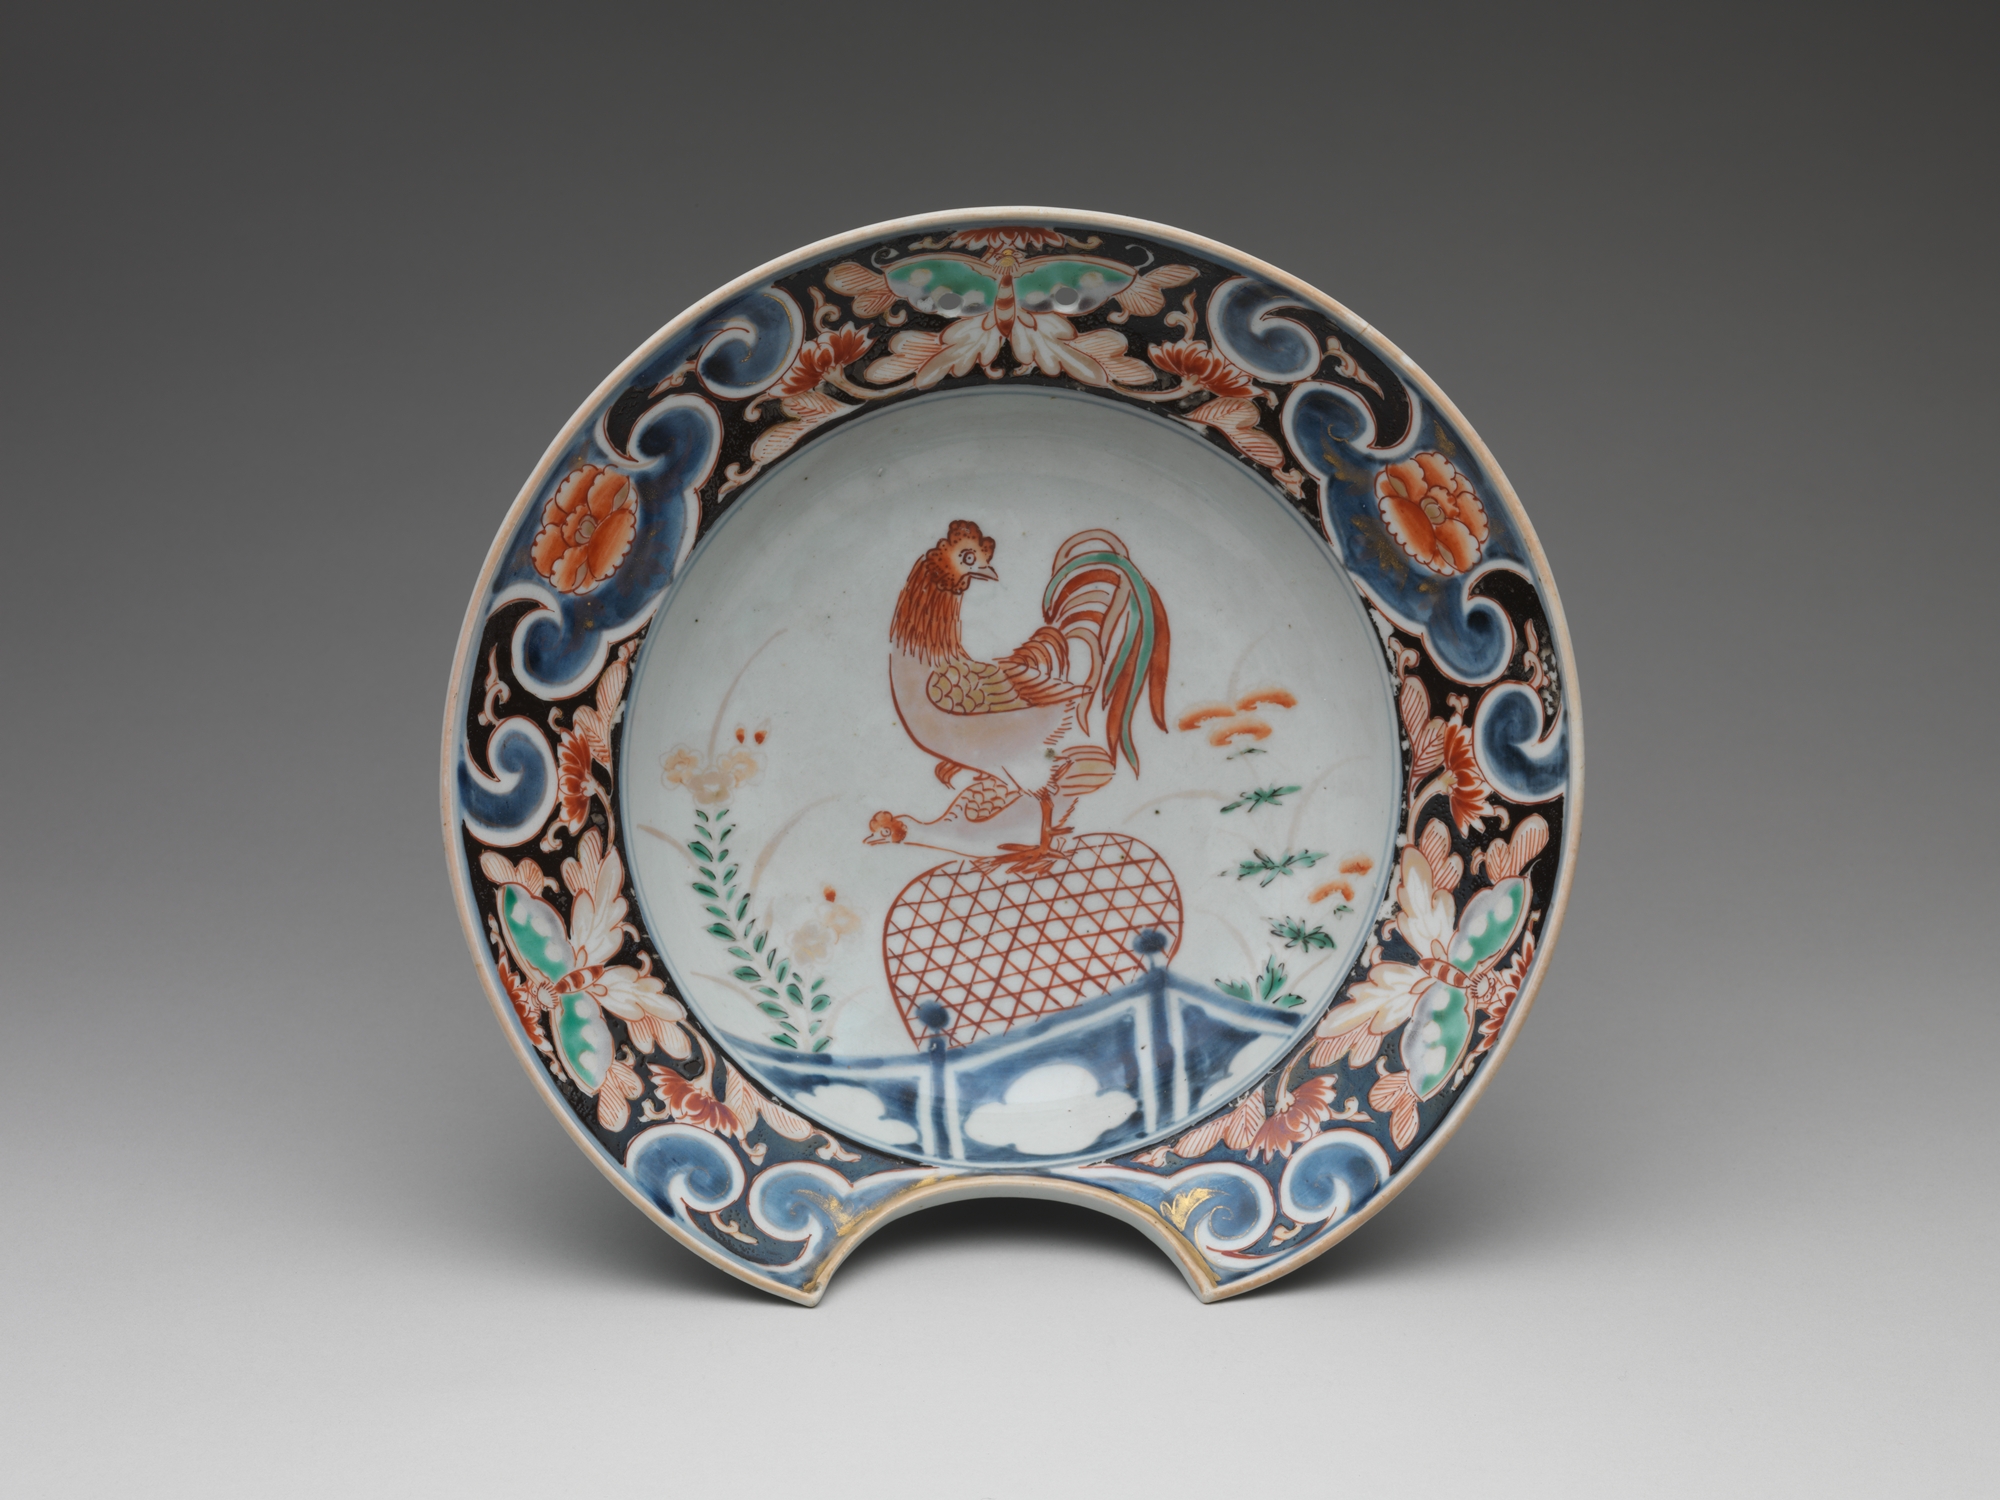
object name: barber's bowl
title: Barber's Bowl with Cockerel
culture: japanese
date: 1667-1733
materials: enamel, porcelain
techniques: overglaze, underglaze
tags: roosters,butterflies,flowers